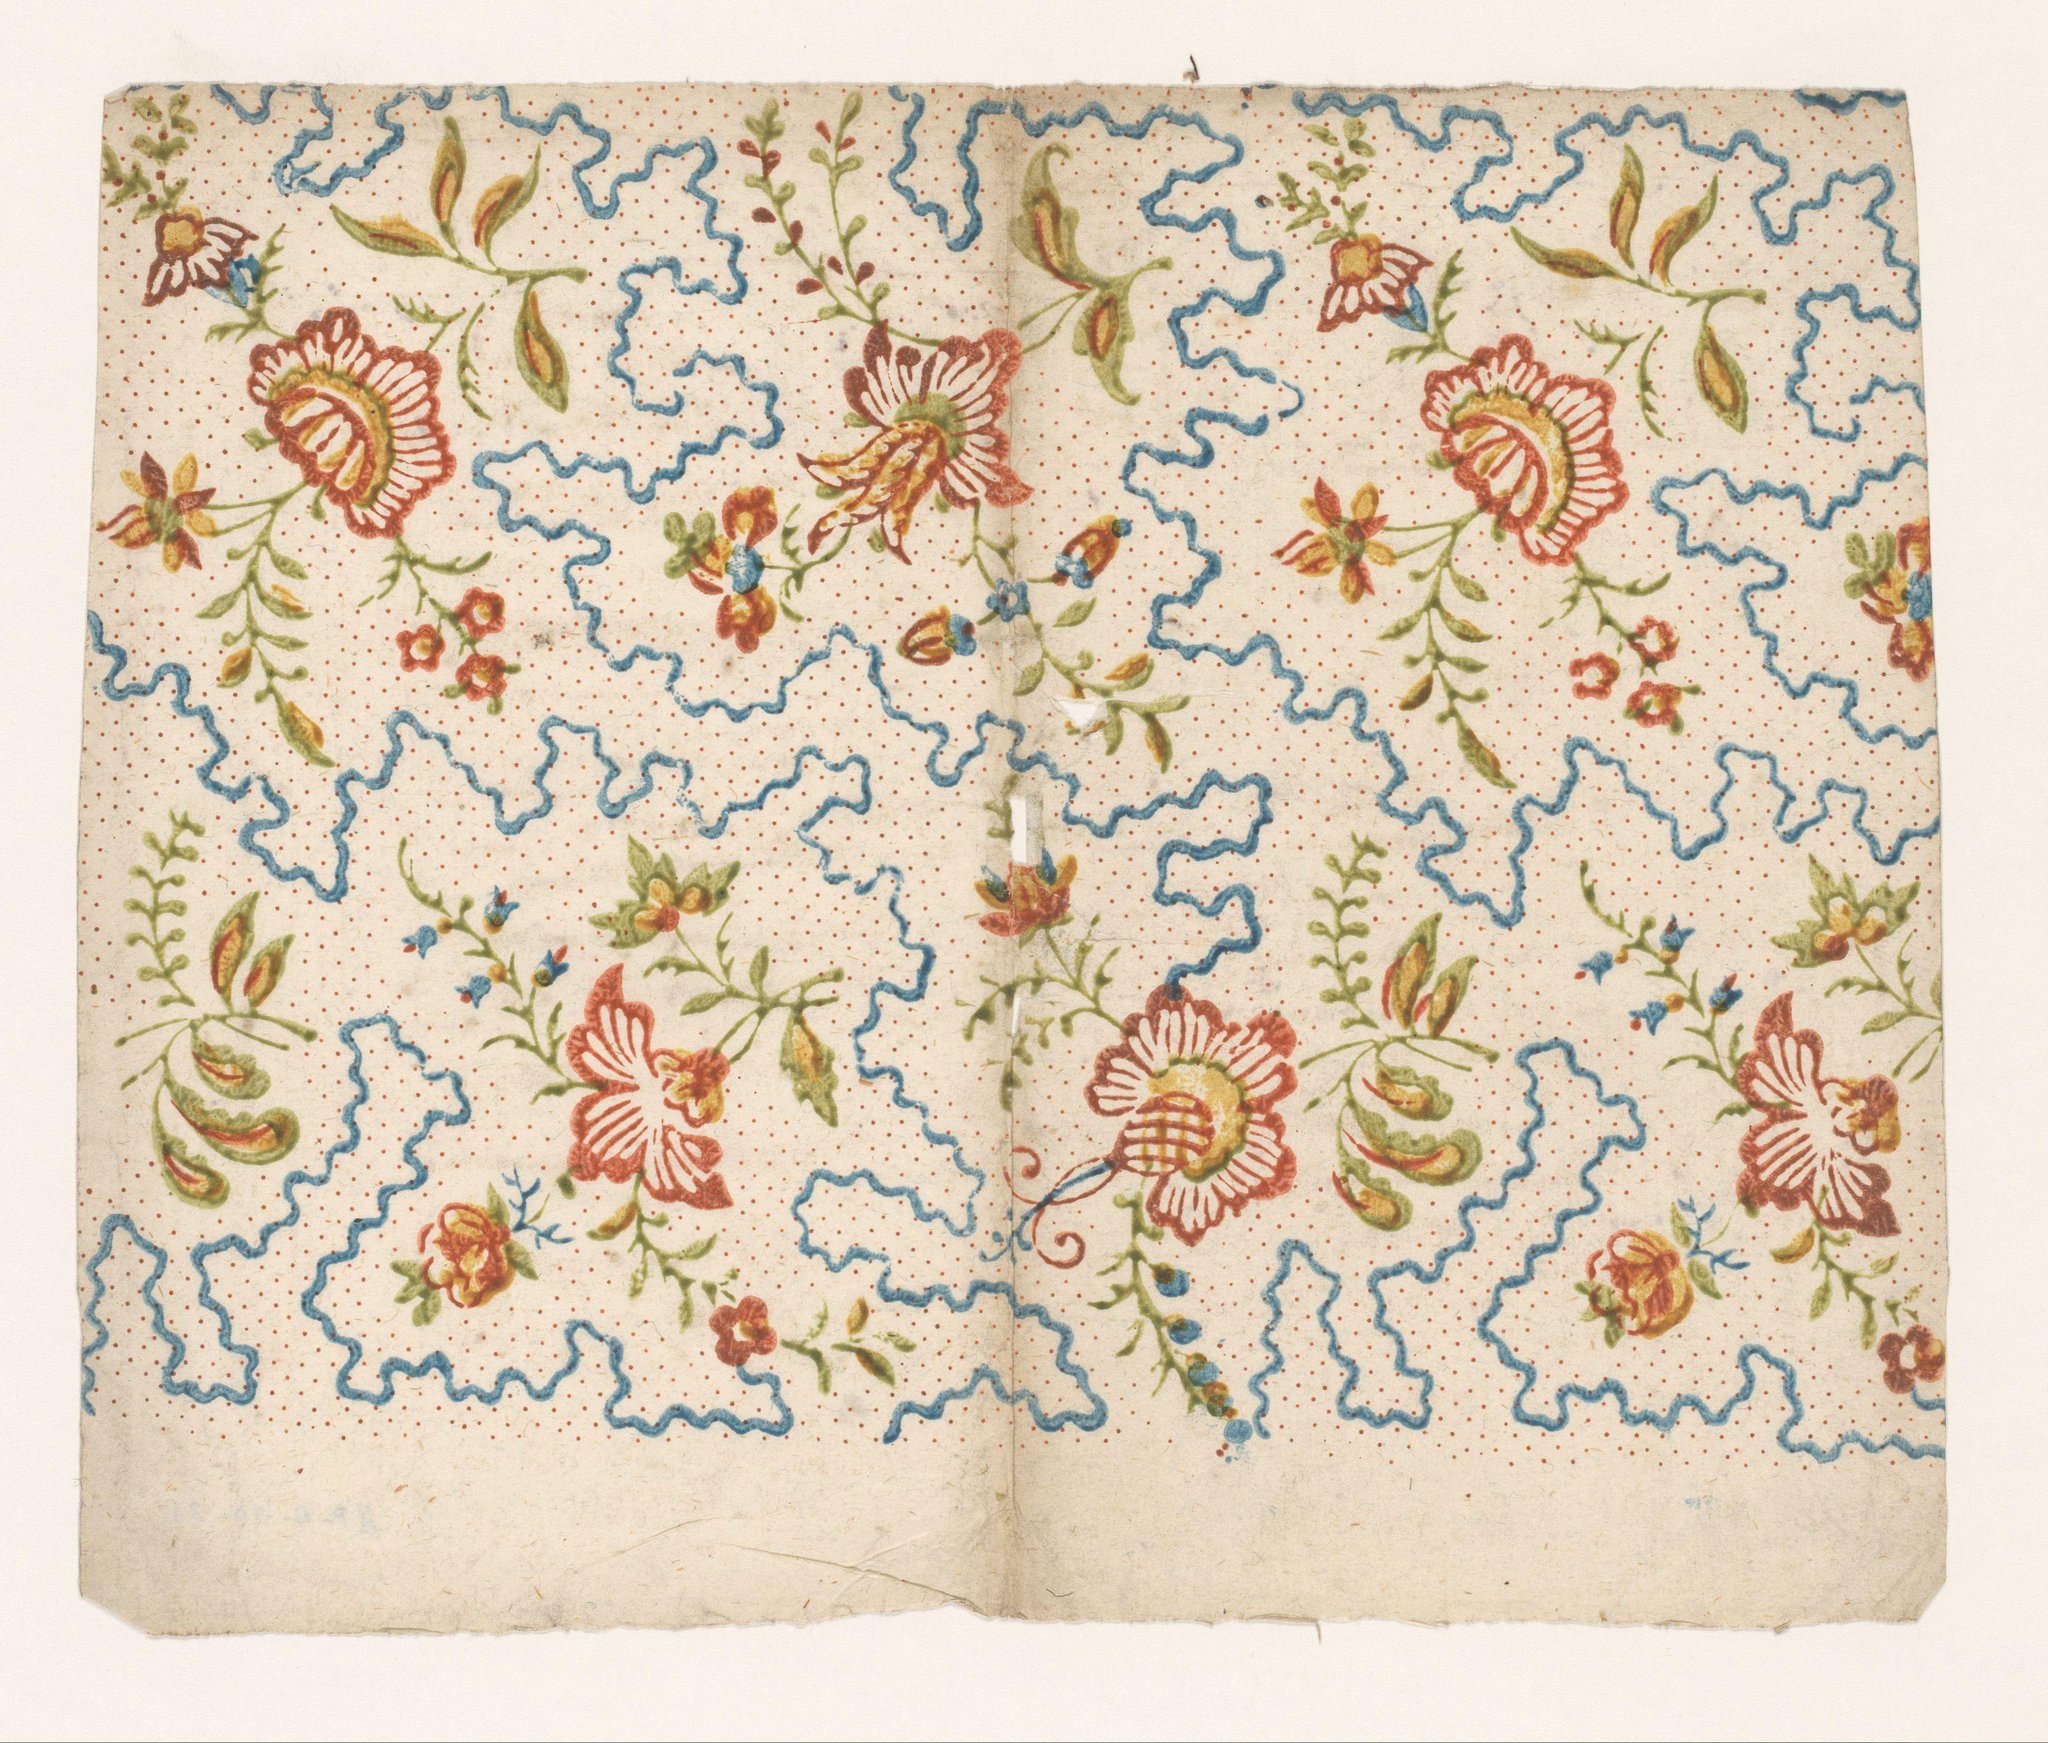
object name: printed paper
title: Blad met strooipatroon van bloemen en takken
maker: Anonymous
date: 1700-1850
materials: paper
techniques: printing block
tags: ornament derived from plant forms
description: Blad met strooipatroon van bloemen en takken met puntenfond met kronkellijnen. Gebruikt als omslag.